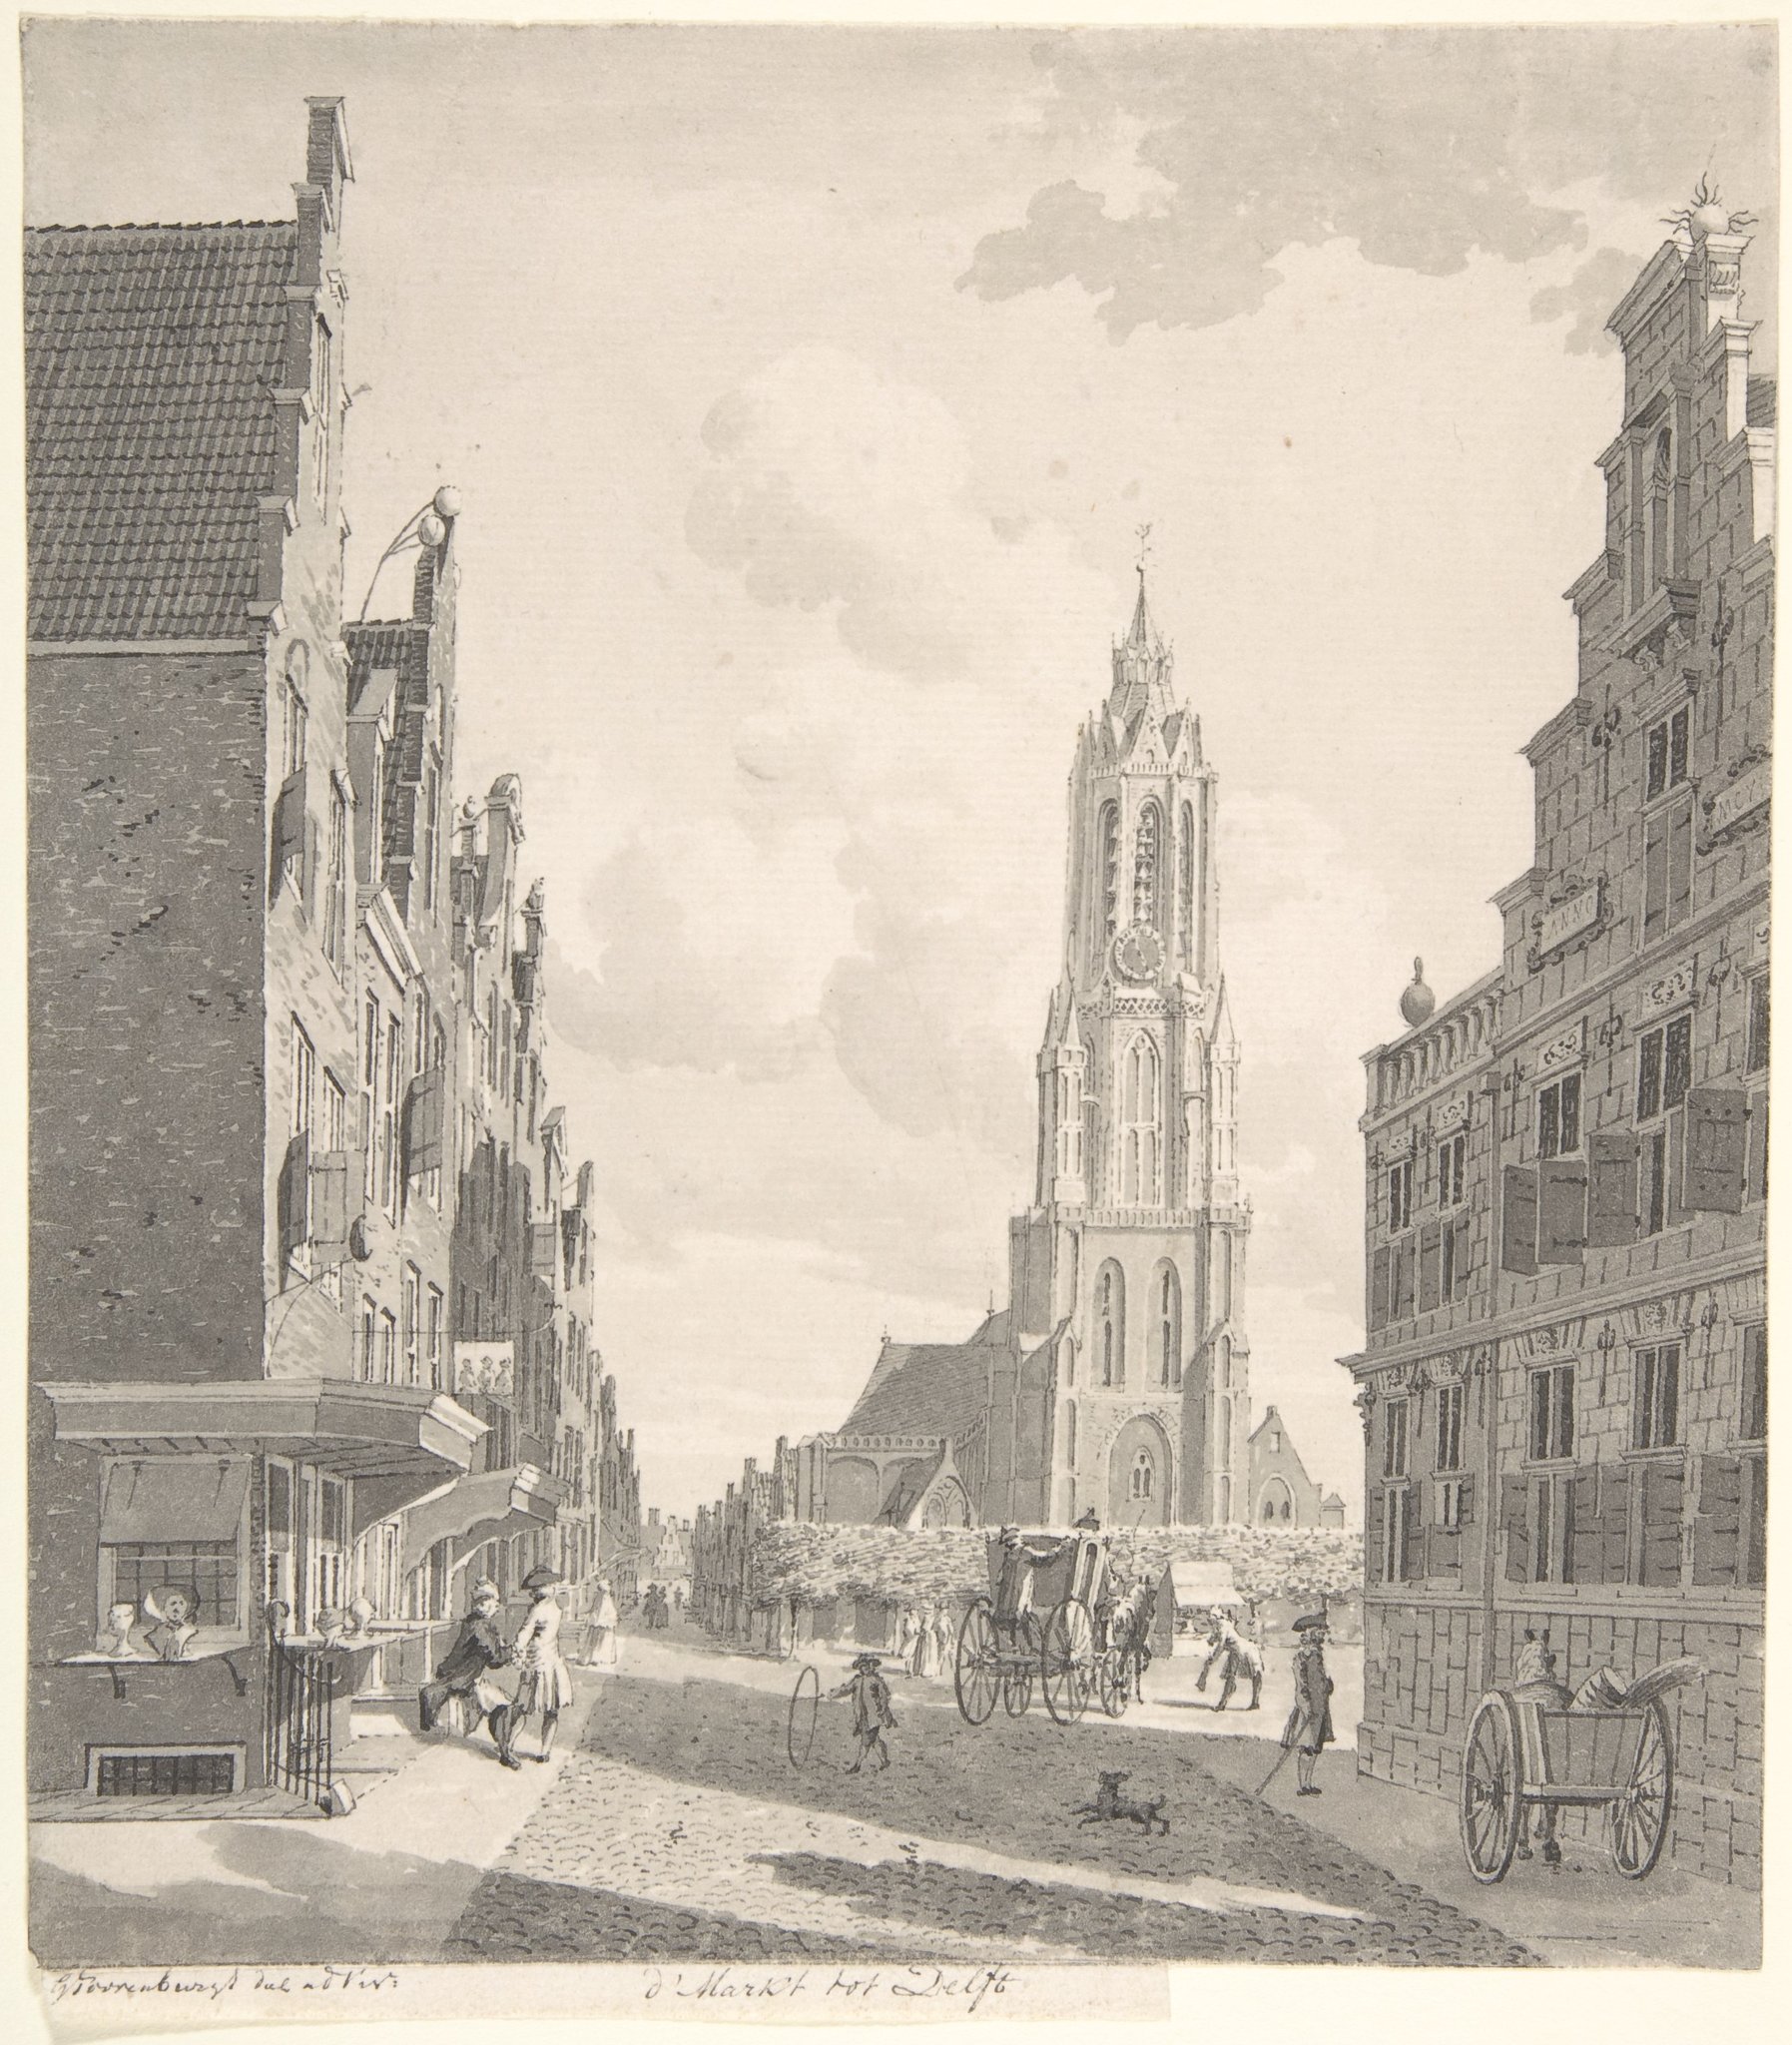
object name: drawing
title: Marketplace of Delft with the Nieuwekerk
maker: gerrit toorenburgh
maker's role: artist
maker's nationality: dutch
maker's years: 1732-1785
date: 1701-1800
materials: ink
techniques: brush, pen, wash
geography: netherlands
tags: buildings,towers,cities,markets,carriages